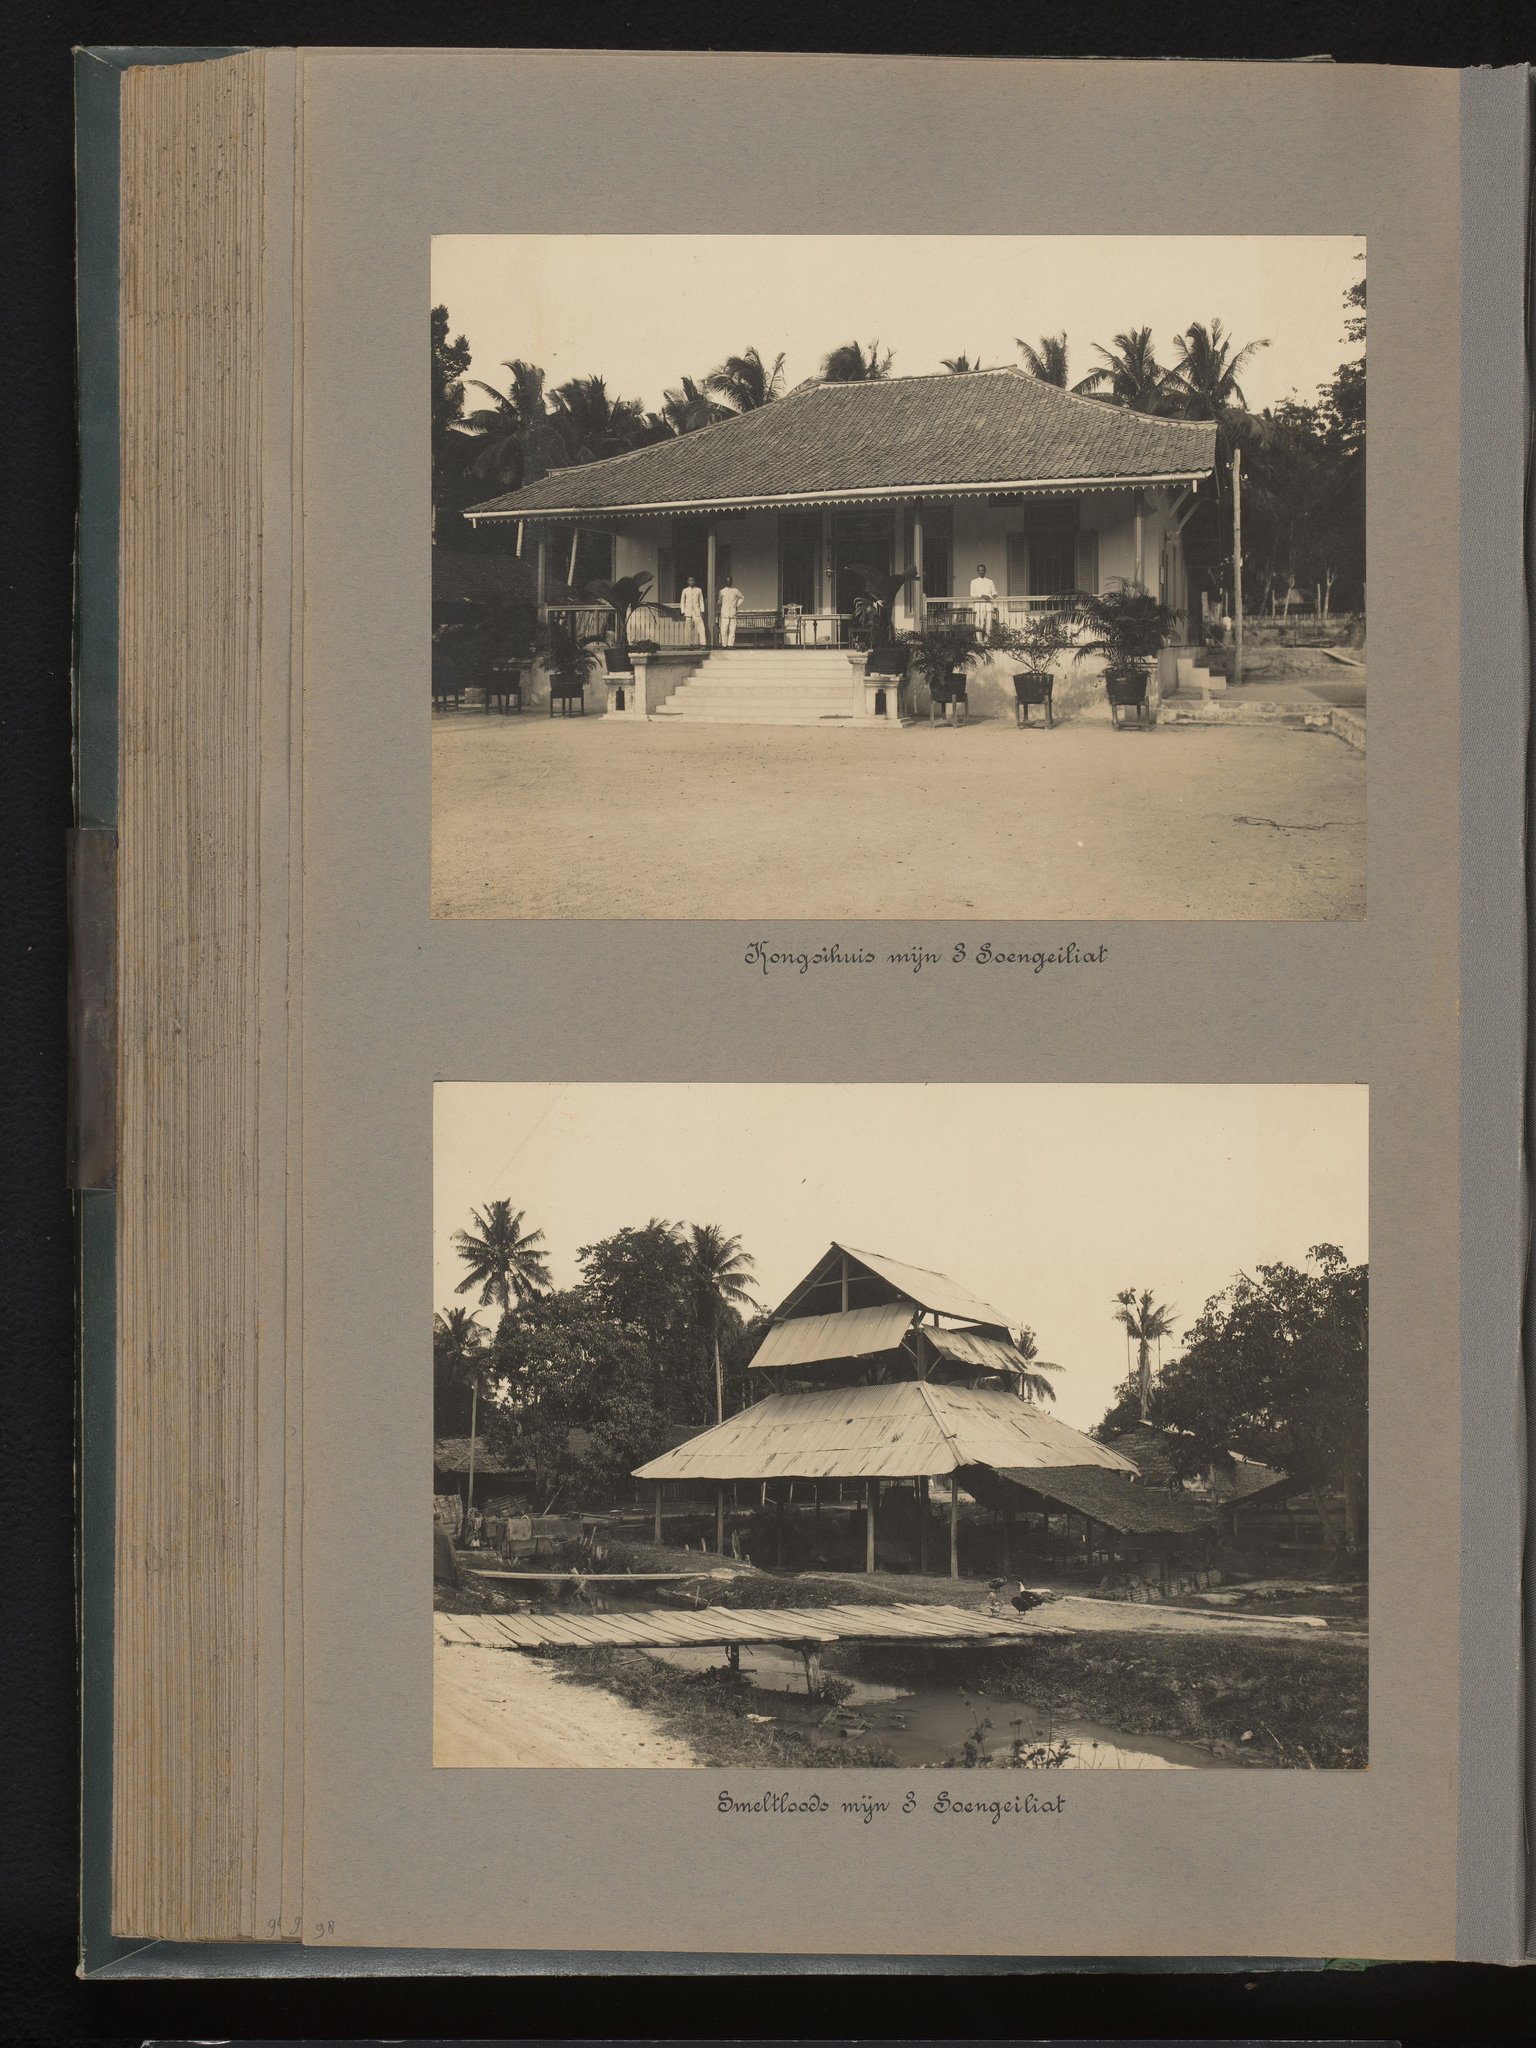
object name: photograph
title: Kongsihuis en smeltloods van de Banka-tinwinning te Soengeiliat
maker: Anonymous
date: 1914-1919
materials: cardboard, photographic support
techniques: gelatin silver print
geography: bangka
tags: robert julius boers, colonial system, mining, smelting, extracting from ore; blast-furnace, modern professional organization, trade union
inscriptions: inscription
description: Albumblad met 2 foto's van een kongsihuis en smeltloods van de Banka-tinwinning te Soengeiliat. Onderdeel van het fotoalbum aangeboden aan Robert Julius Boers bij zijn vertrek naar Nederland in 1919 door het personeel van de Banka-tinwinning.